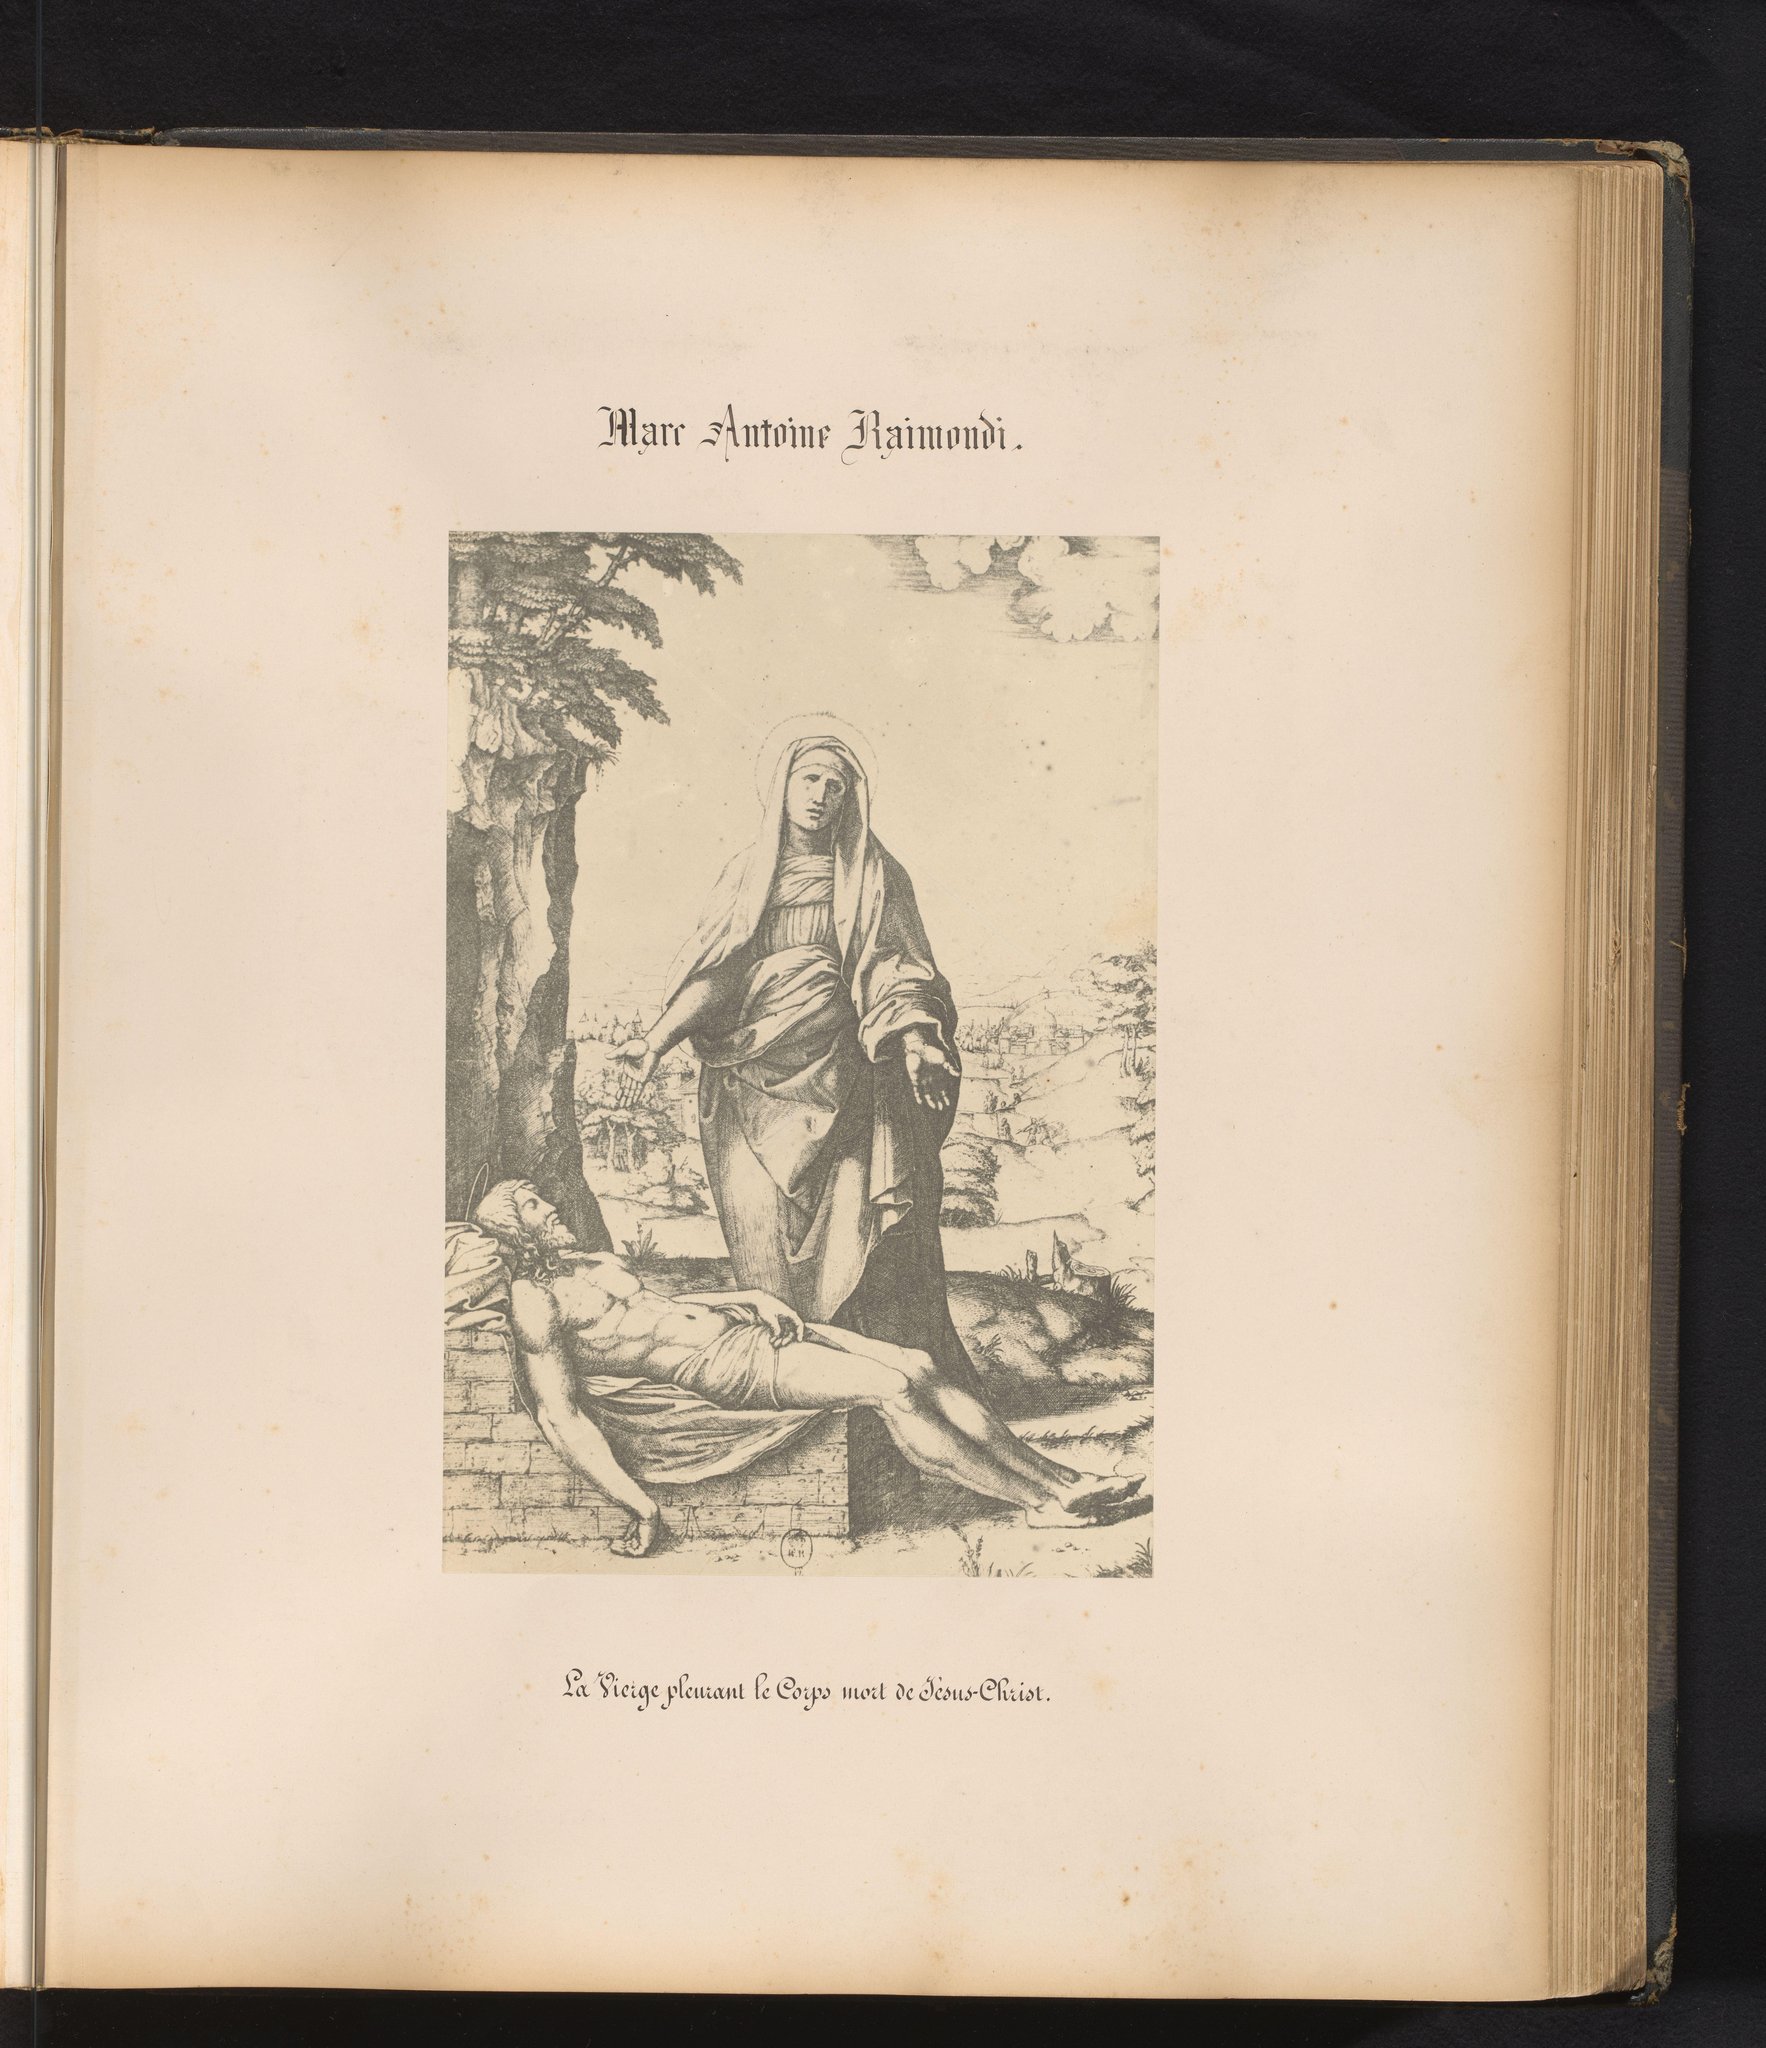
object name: reproduction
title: Fotoreproductie van een gravure van de bewening van Christus door Maria, door Marcantonio Raimondi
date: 1848-1853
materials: photographic support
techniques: salted paper print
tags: 'pietà ', 'vesperbild', 'marienklage' (no others present): christ, either with or without crown of thorns, mourned by mary